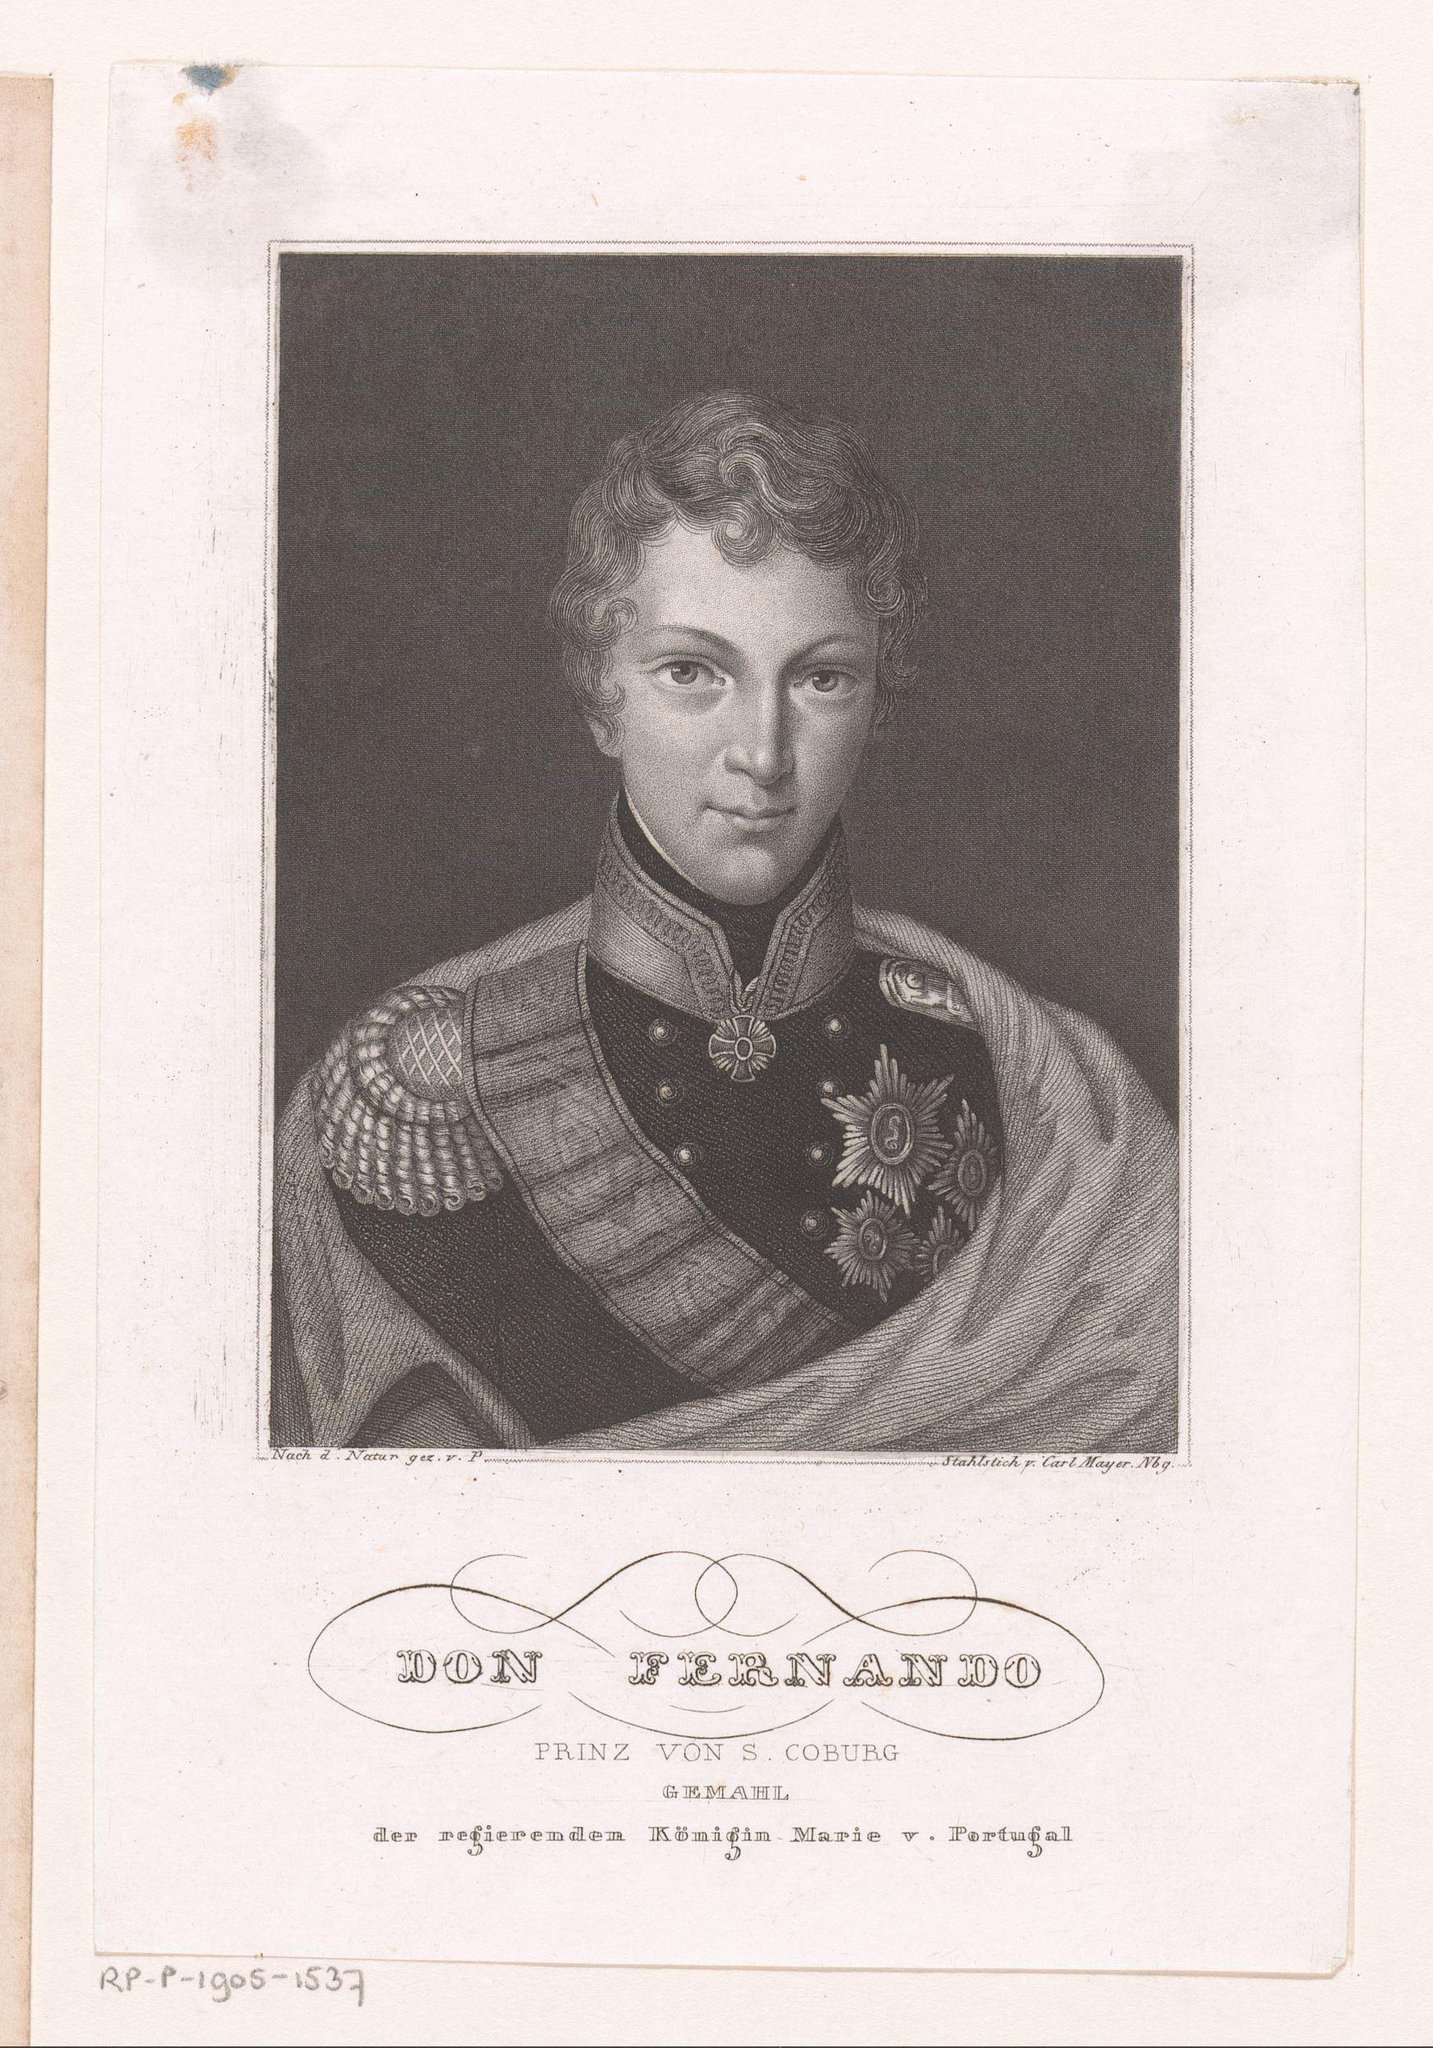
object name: print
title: Tijdgenoten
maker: carl mayer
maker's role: print maker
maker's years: 1798-1868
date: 1829-1840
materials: paper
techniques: engraving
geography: nuremberg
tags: vienna, historical persons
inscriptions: collector's mark: Lugt 2228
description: Vermoedelijk afkomstig uit de portretserie 'Zeitgenossen', uitgegeven tussen 1829 en circa 1840.